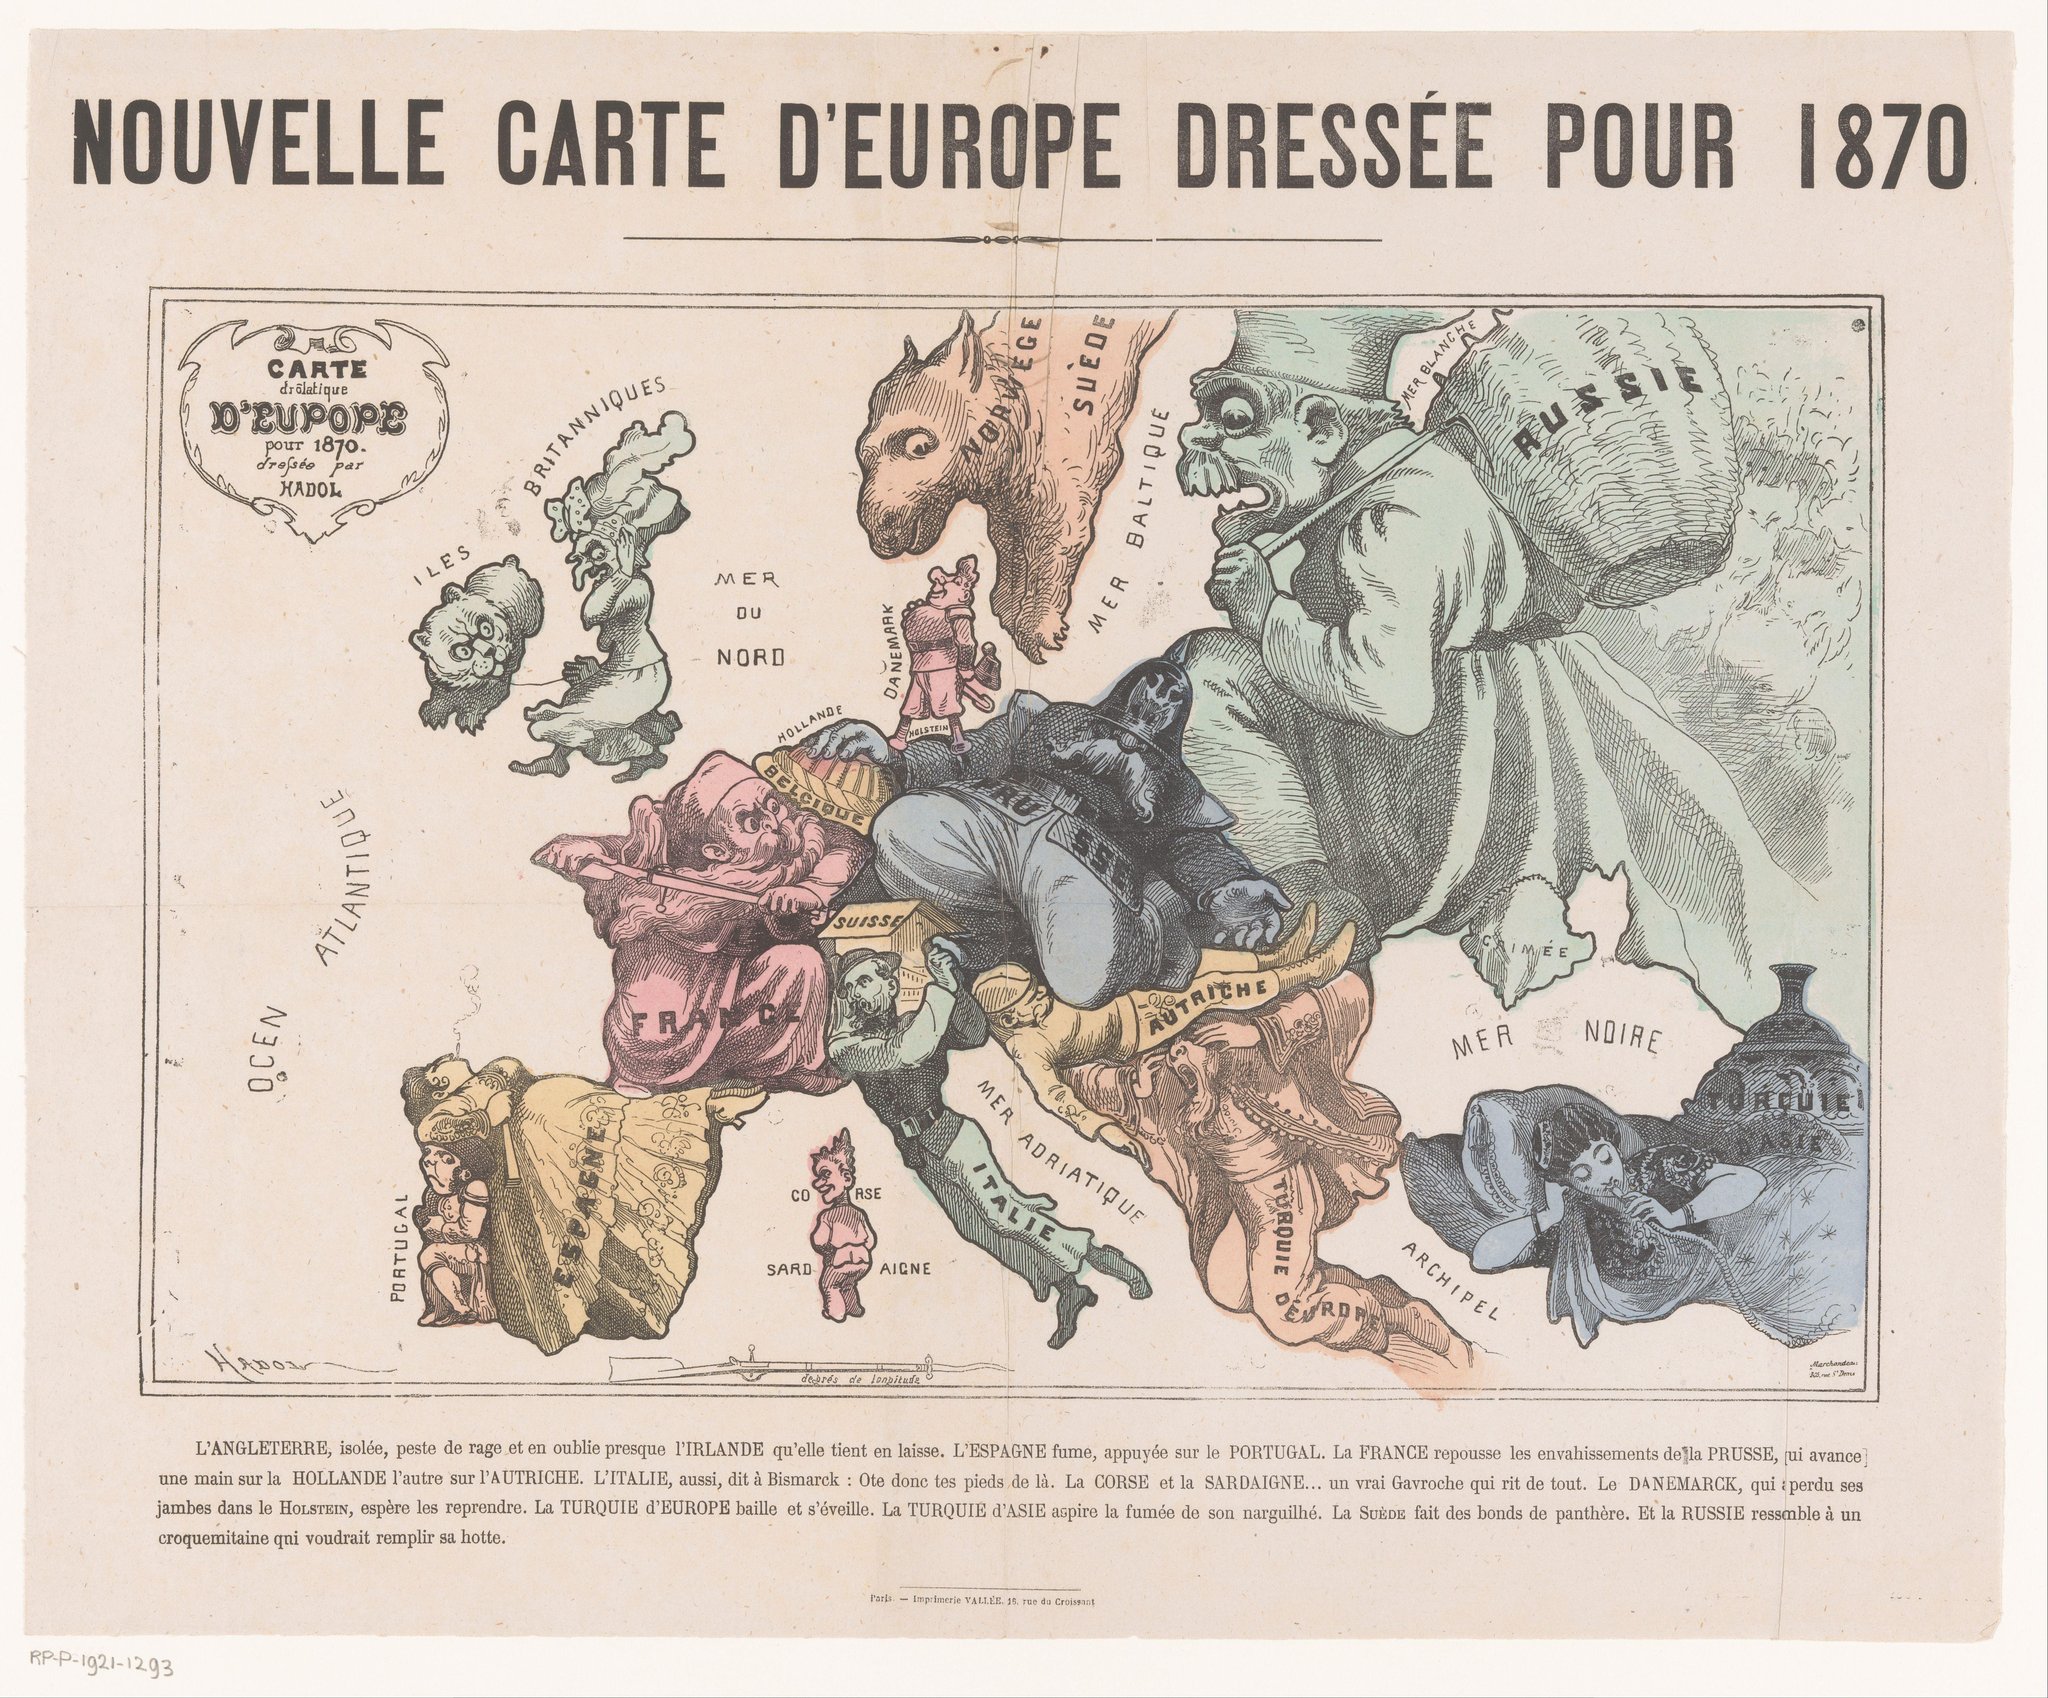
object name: print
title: Nouvelle carte d'Europe dressée pour 1870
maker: paul hadol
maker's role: print maker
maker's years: 1835-1875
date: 1870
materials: paper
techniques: engraving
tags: (map of) europe, political caricatures and satires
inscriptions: collector's mark: Lugt 2228